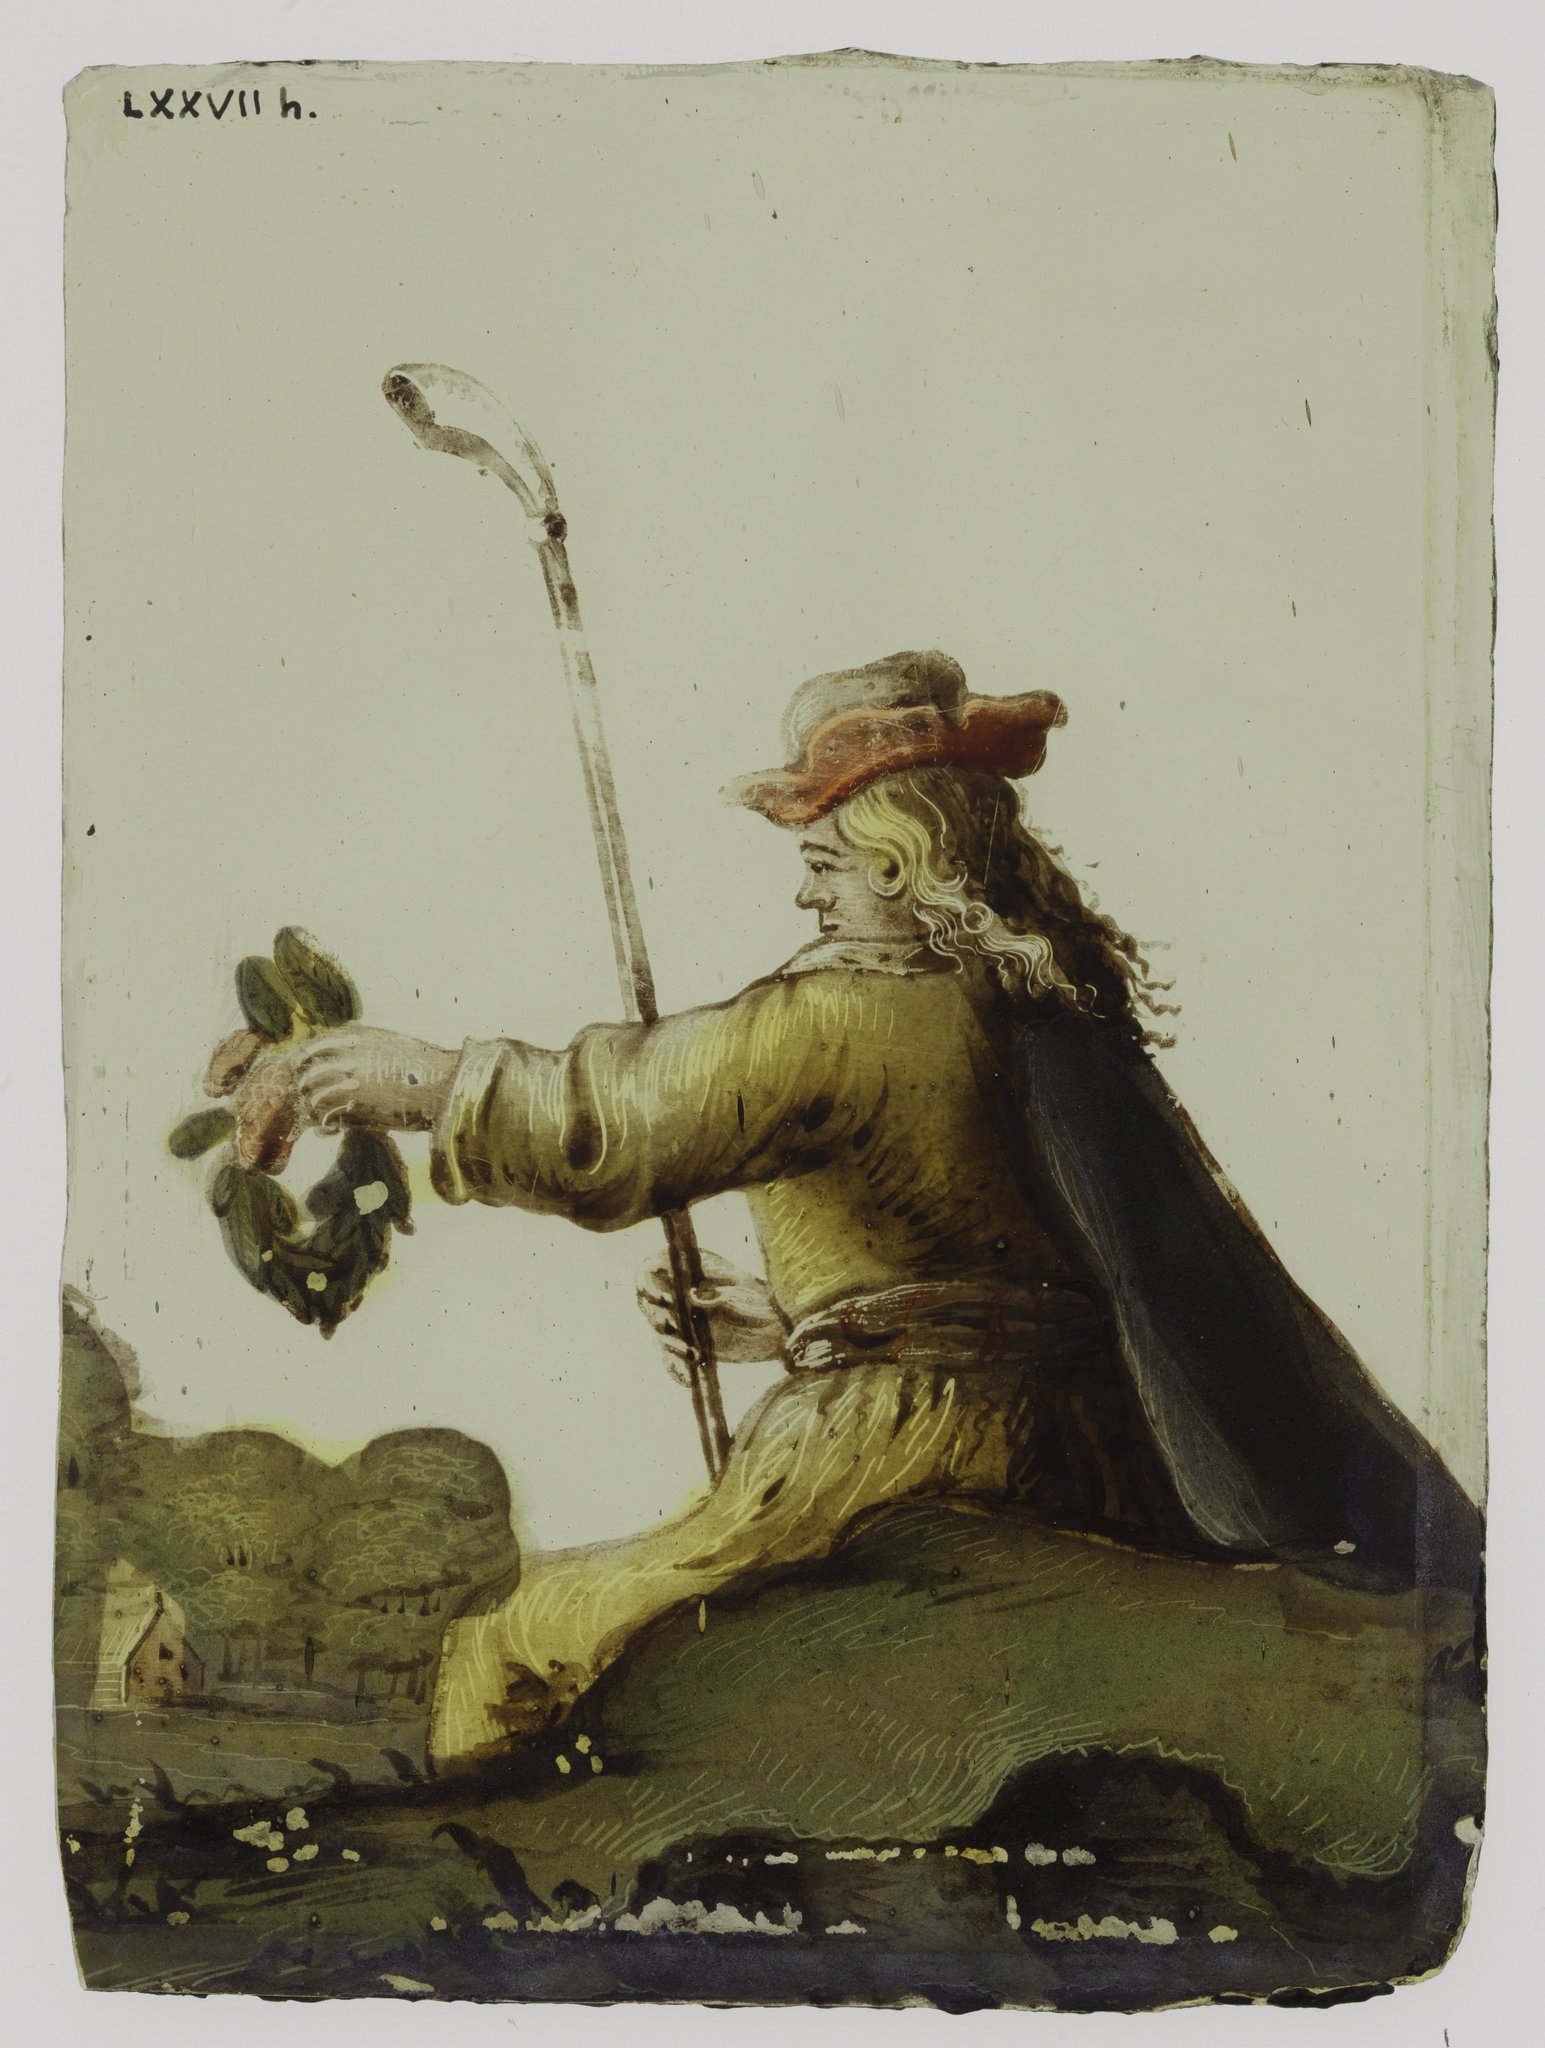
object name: light window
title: Ruit met herder met staf en krans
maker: Anonymous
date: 1650-1675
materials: glass, lead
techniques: enamel painting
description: Een ruit met emailschildering van een herder met staf en krans.